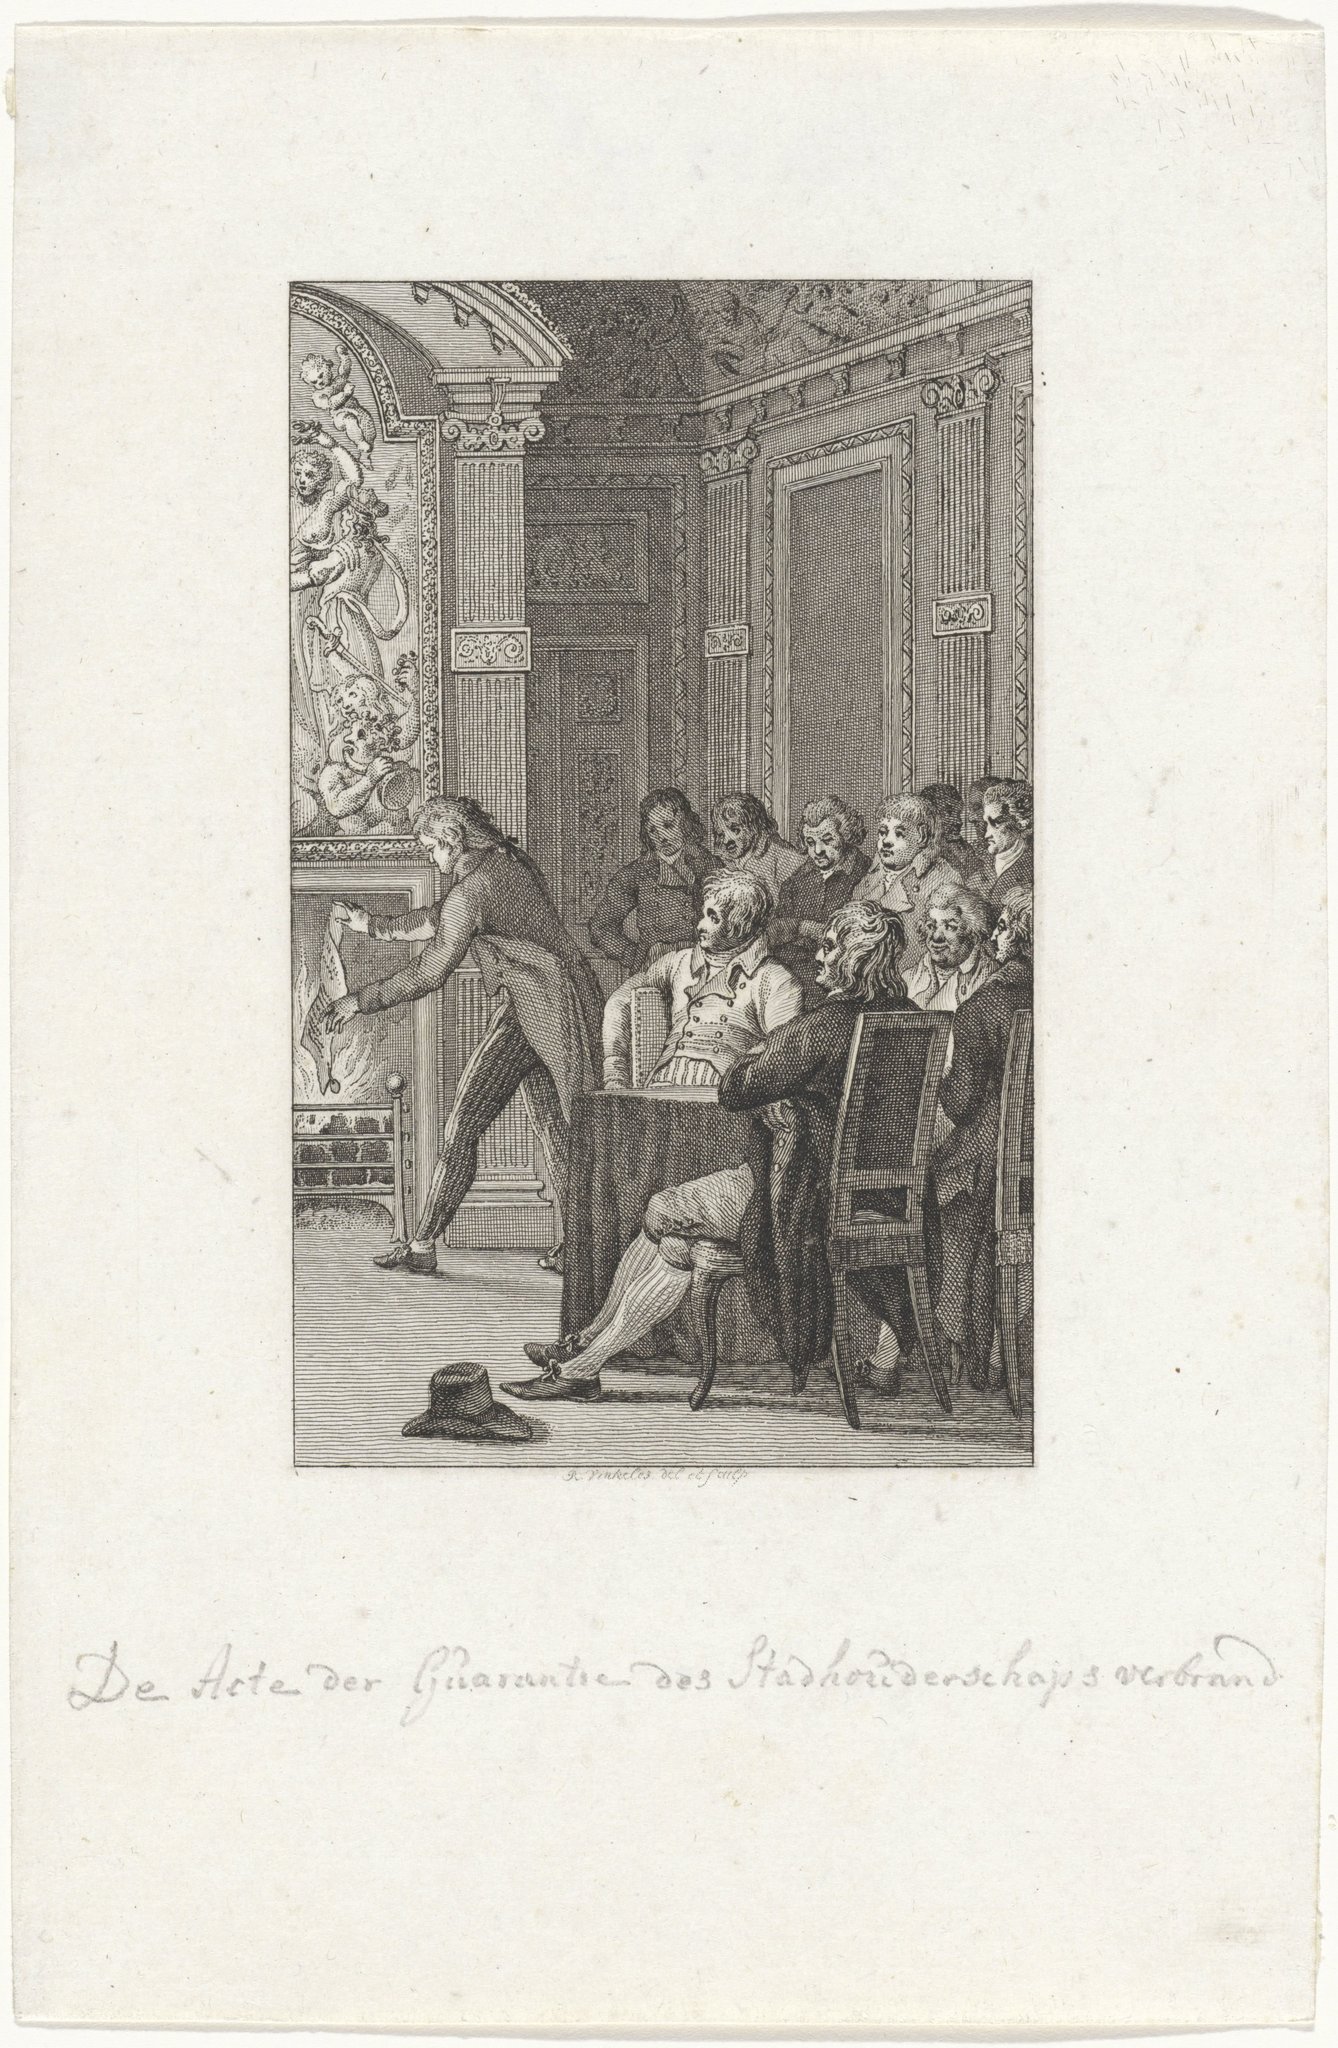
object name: print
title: Van Laar verbrandt de Acte van Garantie, 1795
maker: reinier vinkeles (i)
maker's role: draughtsman, print maker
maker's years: 1741-1816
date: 1803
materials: paper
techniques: engraving, etching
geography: amsterdam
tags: measures taken by revolutionary council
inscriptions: collector's mark: Lugt 2166, collector's mark: Lugt 240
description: Gebruikt als illustratie in:P.A. Loosjes. Vaderlandsche historie, vervattende de geschiedenissen, der Vereenigde Nederlanden (...). Ten onmiddelyken vervolge van Wagenaar's Vaderlandsche historie. Amsterdam: Johannes Allart, dl. 30 (1803).